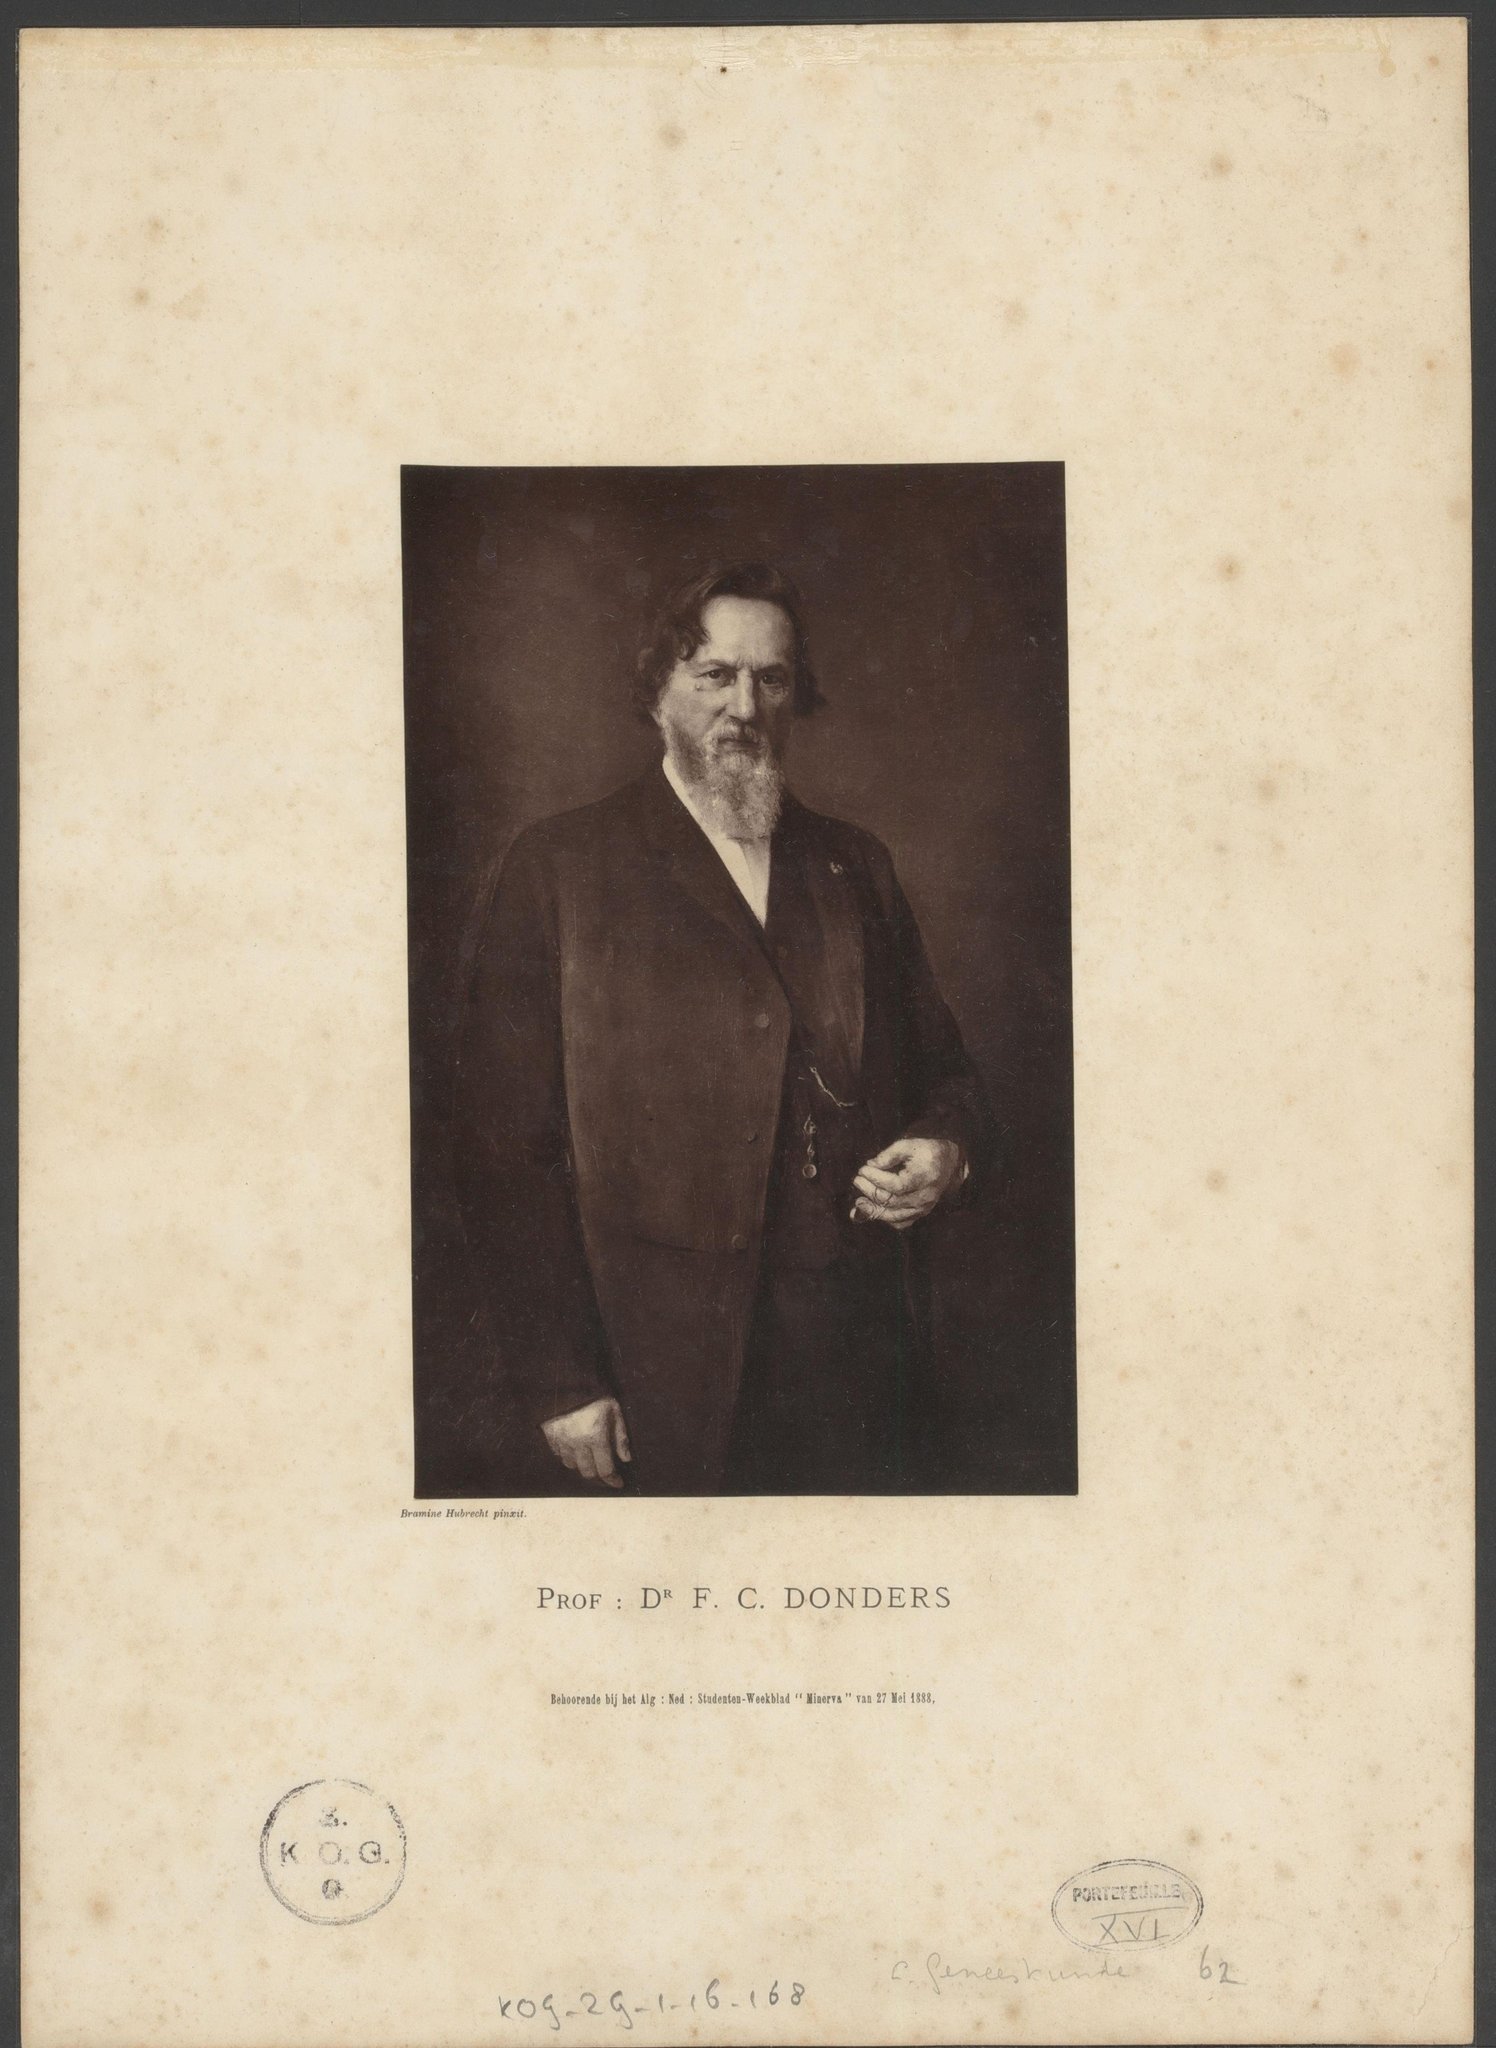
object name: photograph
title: Prof: Dr. F.C. Donders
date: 1888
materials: paper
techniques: carbon print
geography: netherlands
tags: utrecht, historical persons, physician, doctor (+ portrait of scholar, scientist)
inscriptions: collector's mark, collector's mark: Lugt 1641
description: Fotoreproductie van het schilderij door Bramine Hubrecht met het portret van Professor Franciscus Donders, fysioloog en oogheelkundige. Kniestuk, staande, met zijn bril in de linkerhand. Gebruikt in: het Alg. Ned. Studenten-Weekblad "Minerva" van 27 mei 1888. Onderwerpsrubrieken binnen de Atlas Zeden en Gewoonten: Onderwijs en Wetenschappen: Geneeskunde.